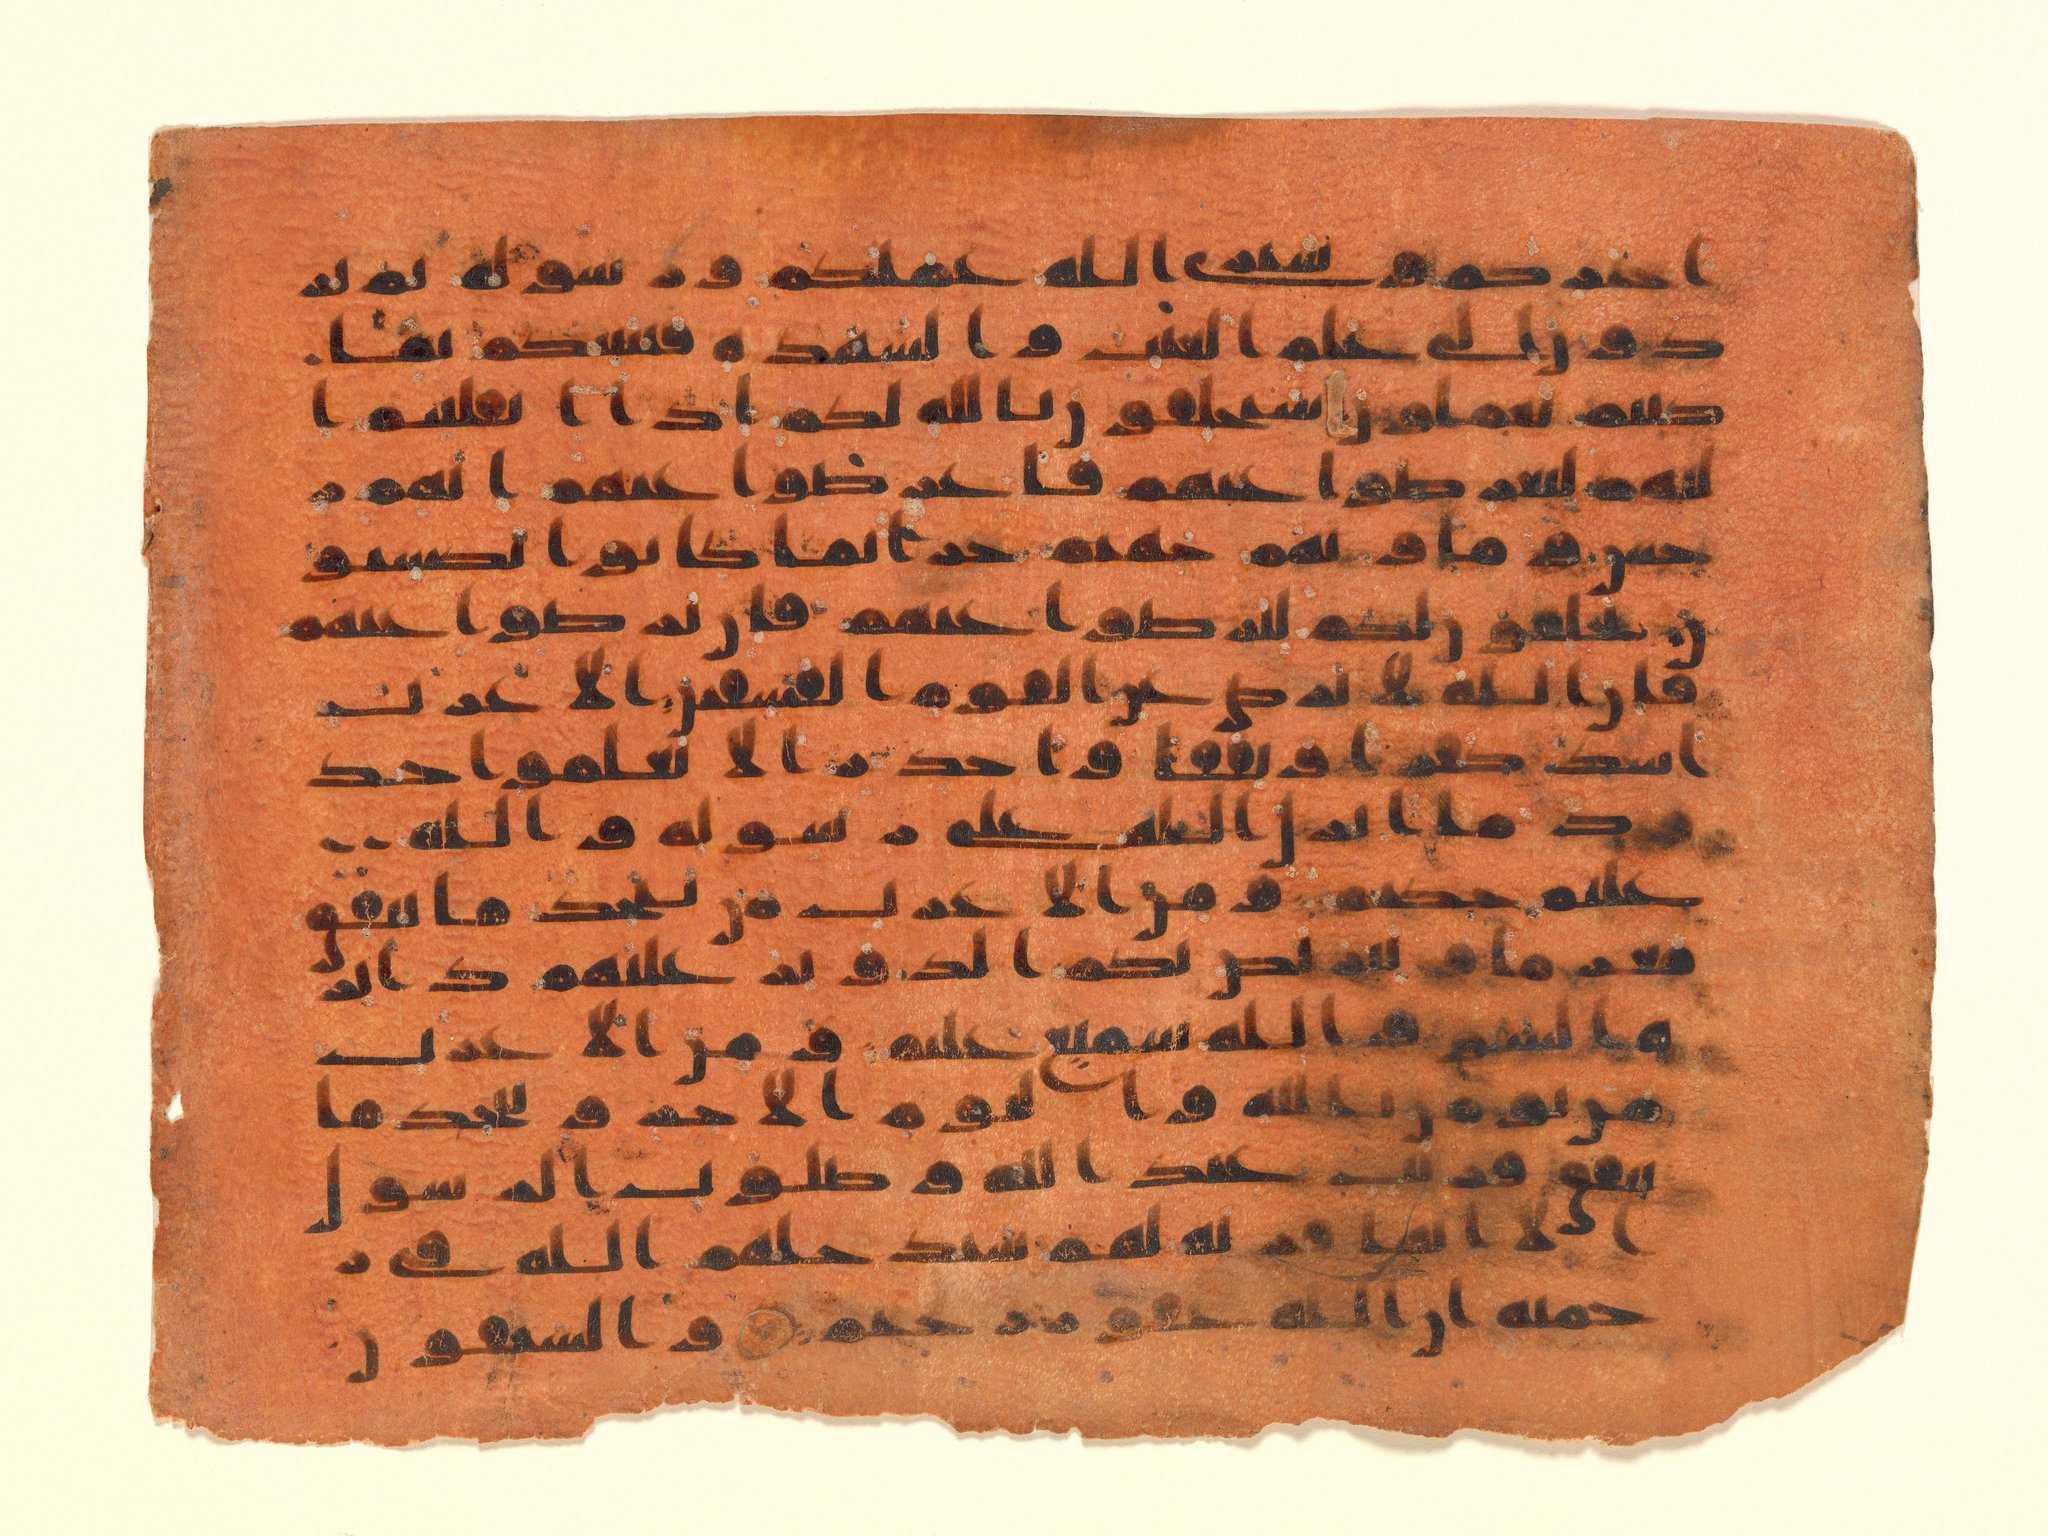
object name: folio from a non illustrated manuscript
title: Folio from a Qur'an Manuscript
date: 801-900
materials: ink, parchment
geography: central islamic lands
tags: arabic,qur'an,calligraphy